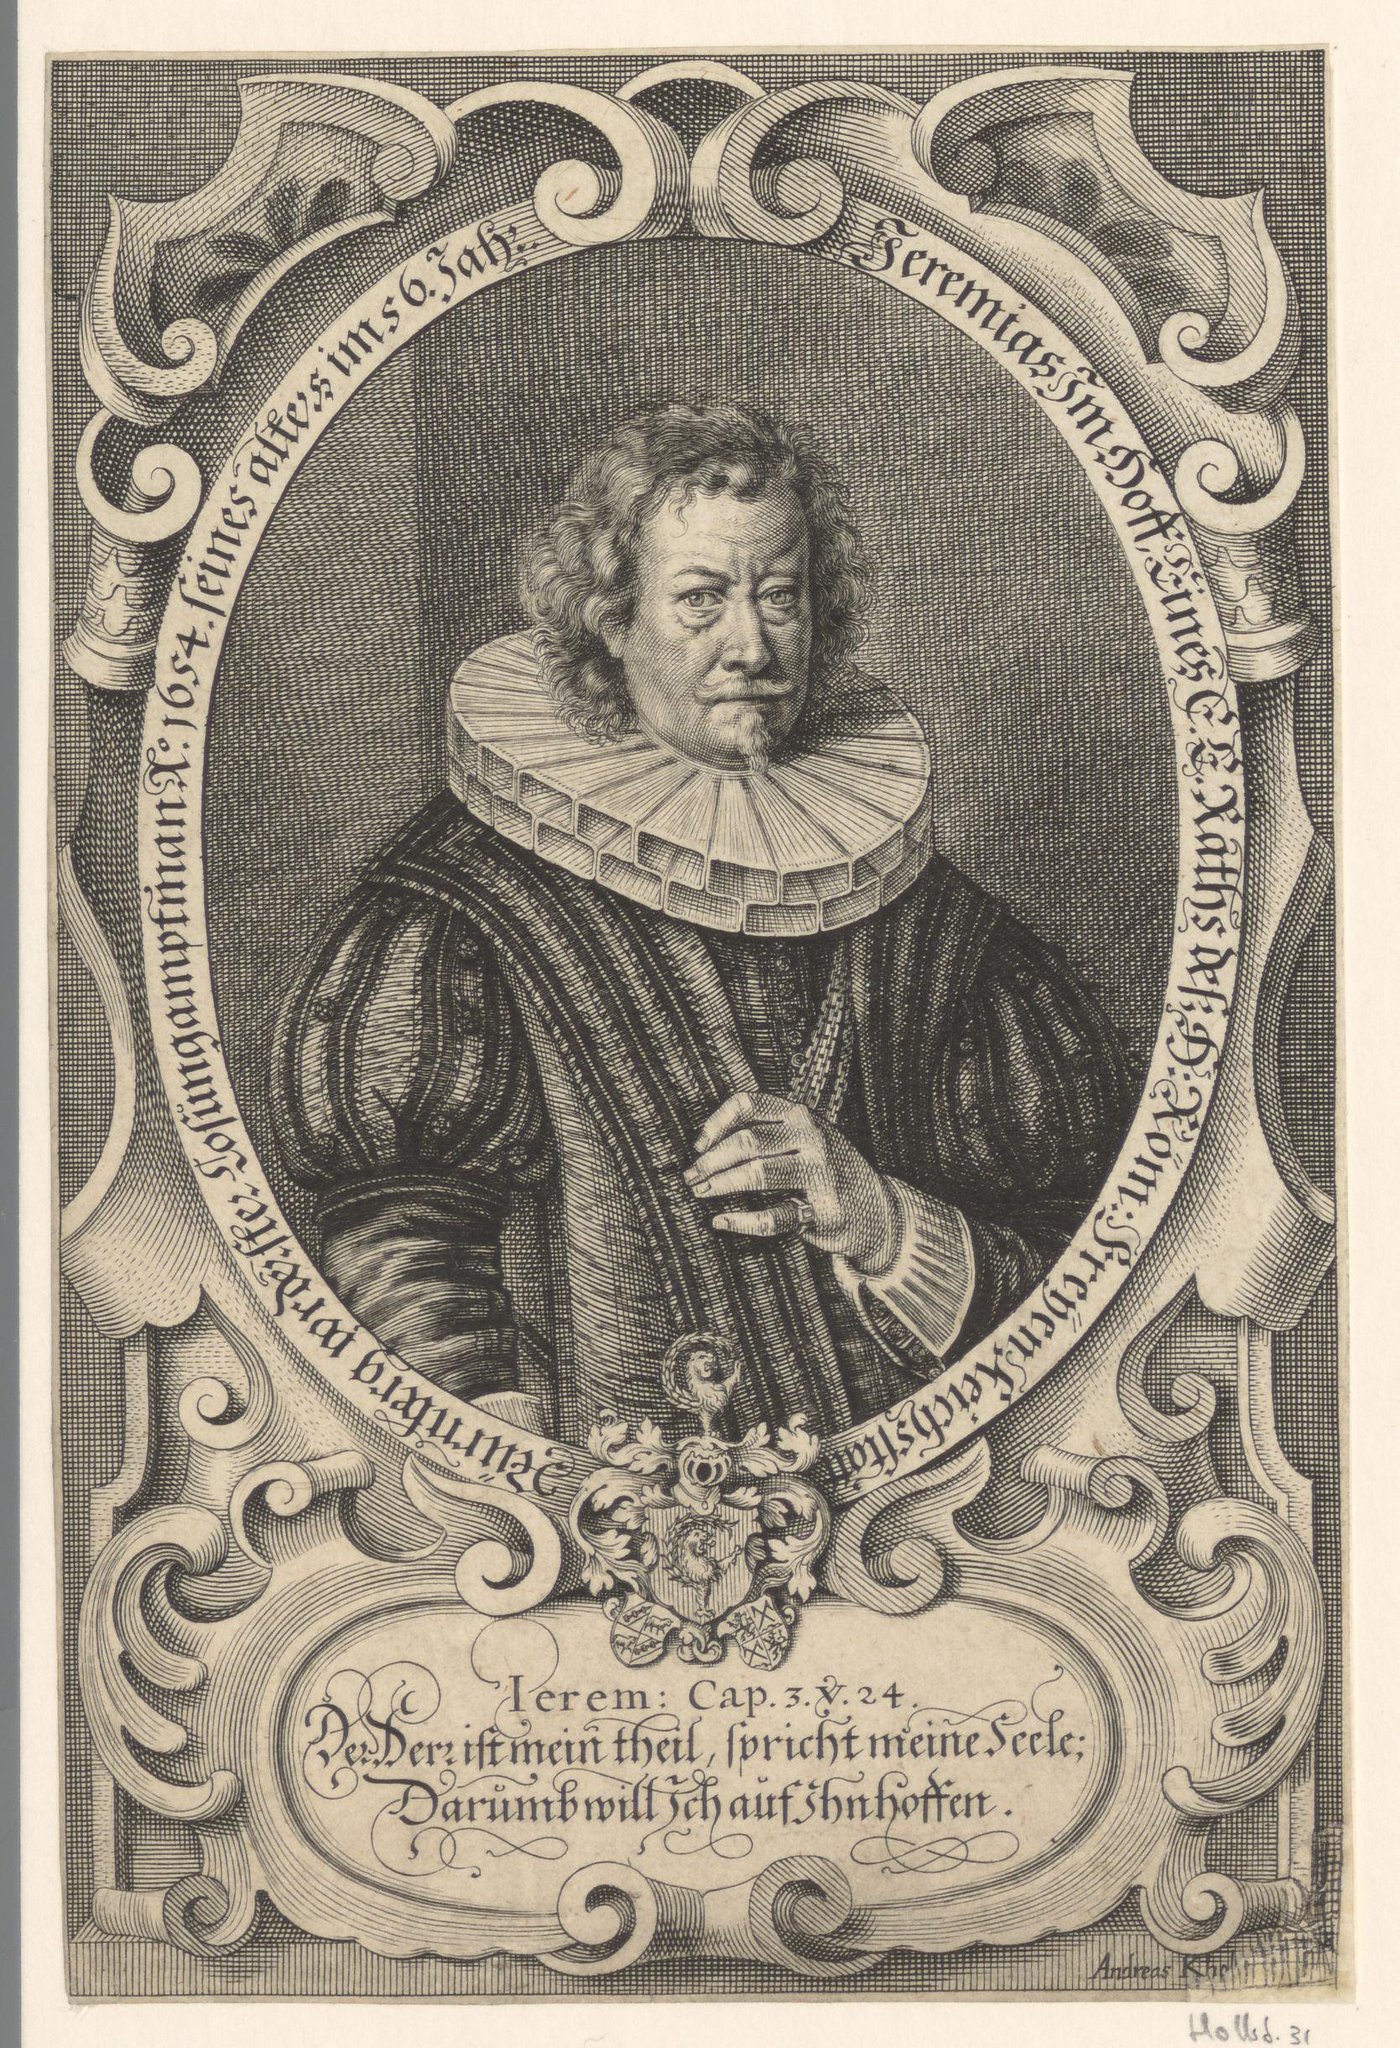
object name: print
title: Portret van Jeremias Imhoff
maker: andreas kohl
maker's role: print maker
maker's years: 1624-1657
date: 1654-1657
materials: paper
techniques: engraving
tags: historical persons, lawyer, attorney at law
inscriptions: collector's mark: Lugt 2228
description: Tekst in het Duits in de omlijsting en in de cartouche, met onderaan een regel uit de Bijbelpassage Jer. 3:24.